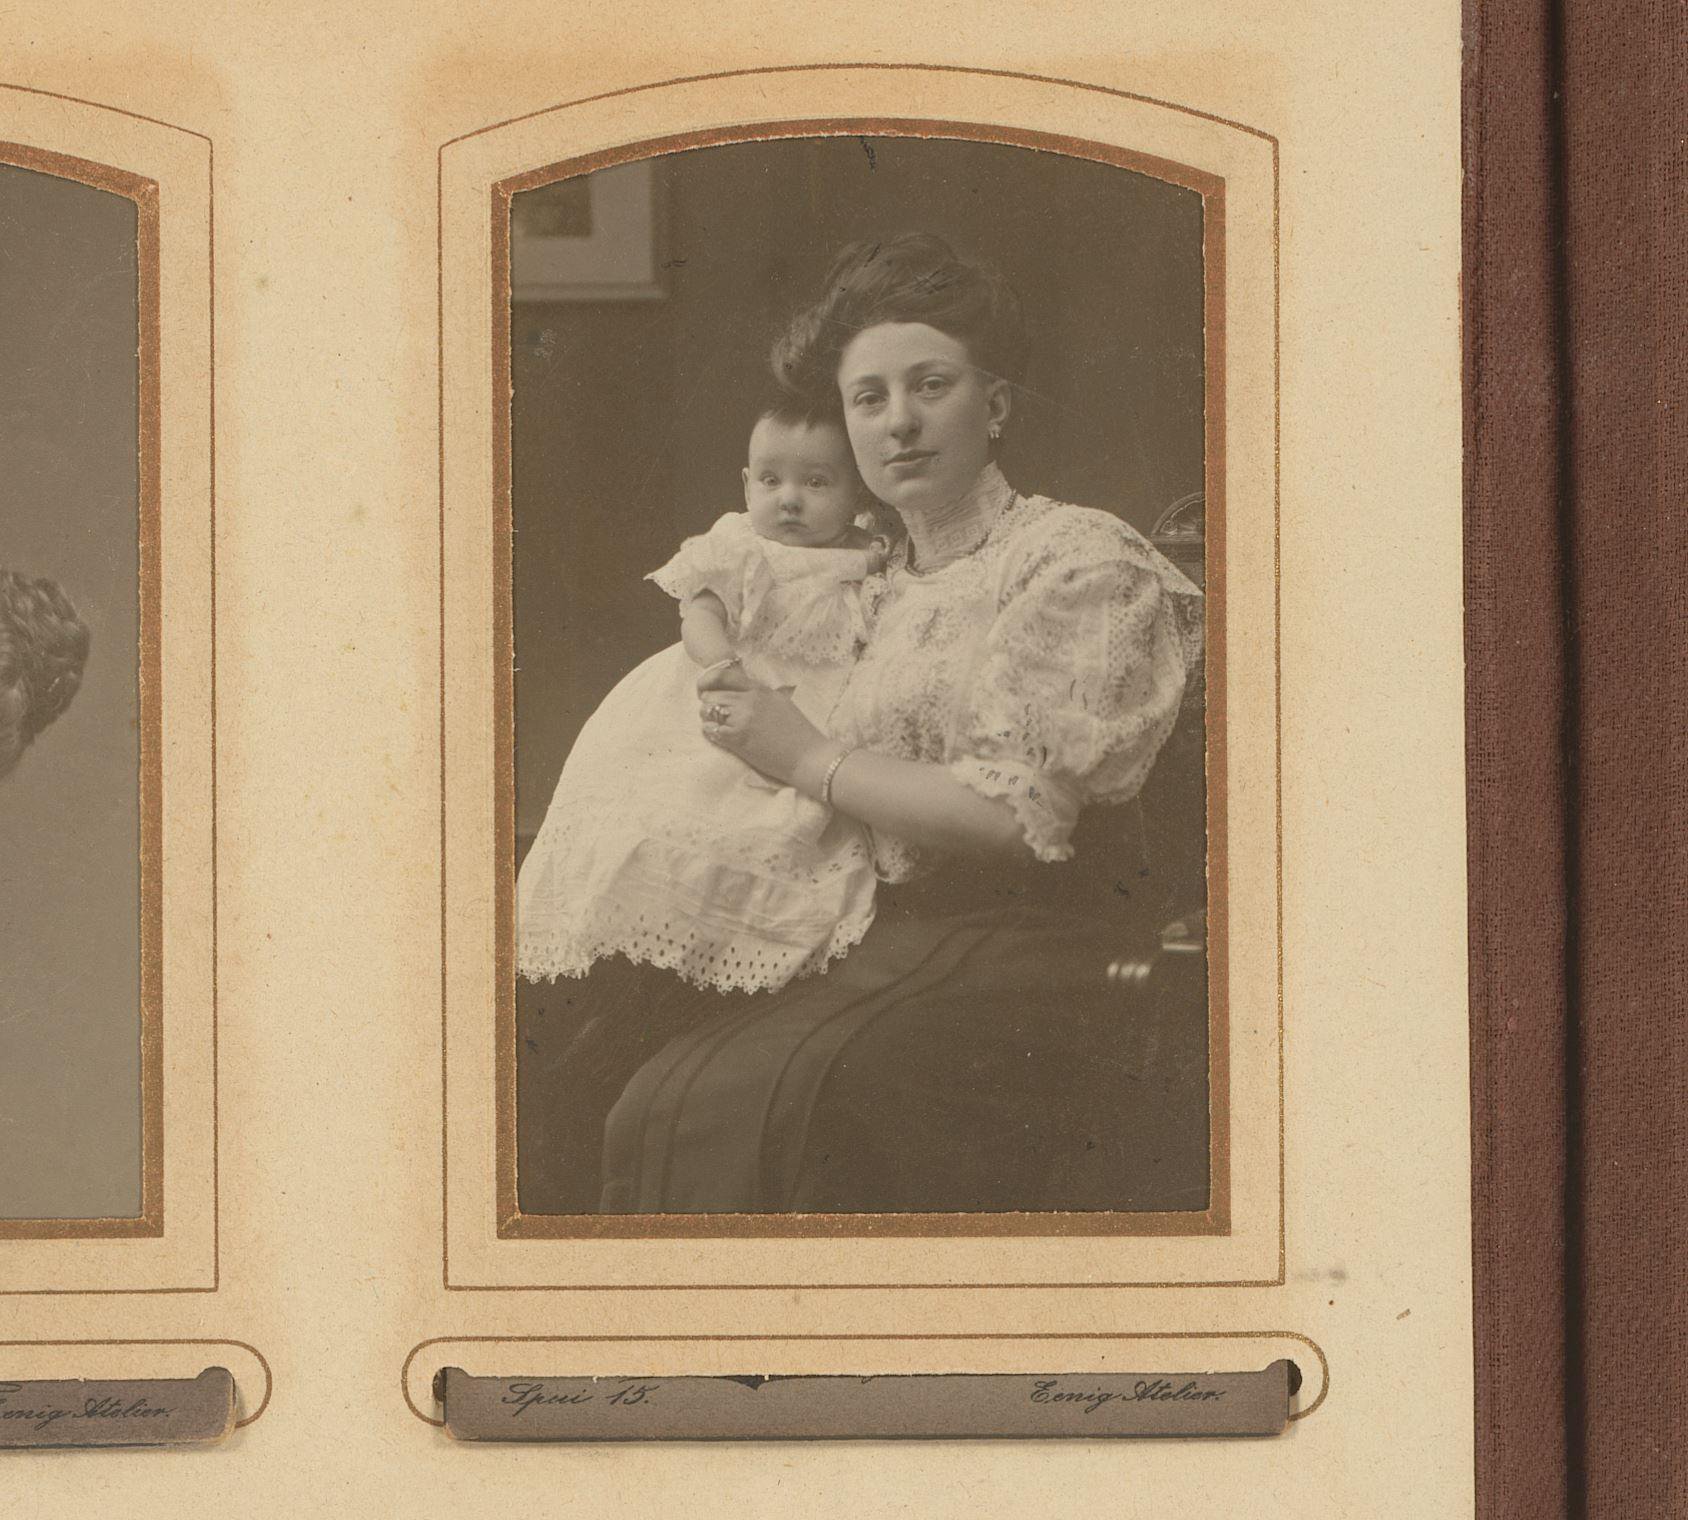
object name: photograph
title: Portret van een moeder met kind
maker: max büttinghausen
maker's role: fotograaf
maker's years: 1847-1906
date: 1880-1906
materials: cardboard, photographic support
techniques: collodion silver print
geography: amsterdam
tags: mother and baby or young child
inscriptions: inscription: ‘M. Büttinghausen/ Spui 15/ Eenig Atelier’